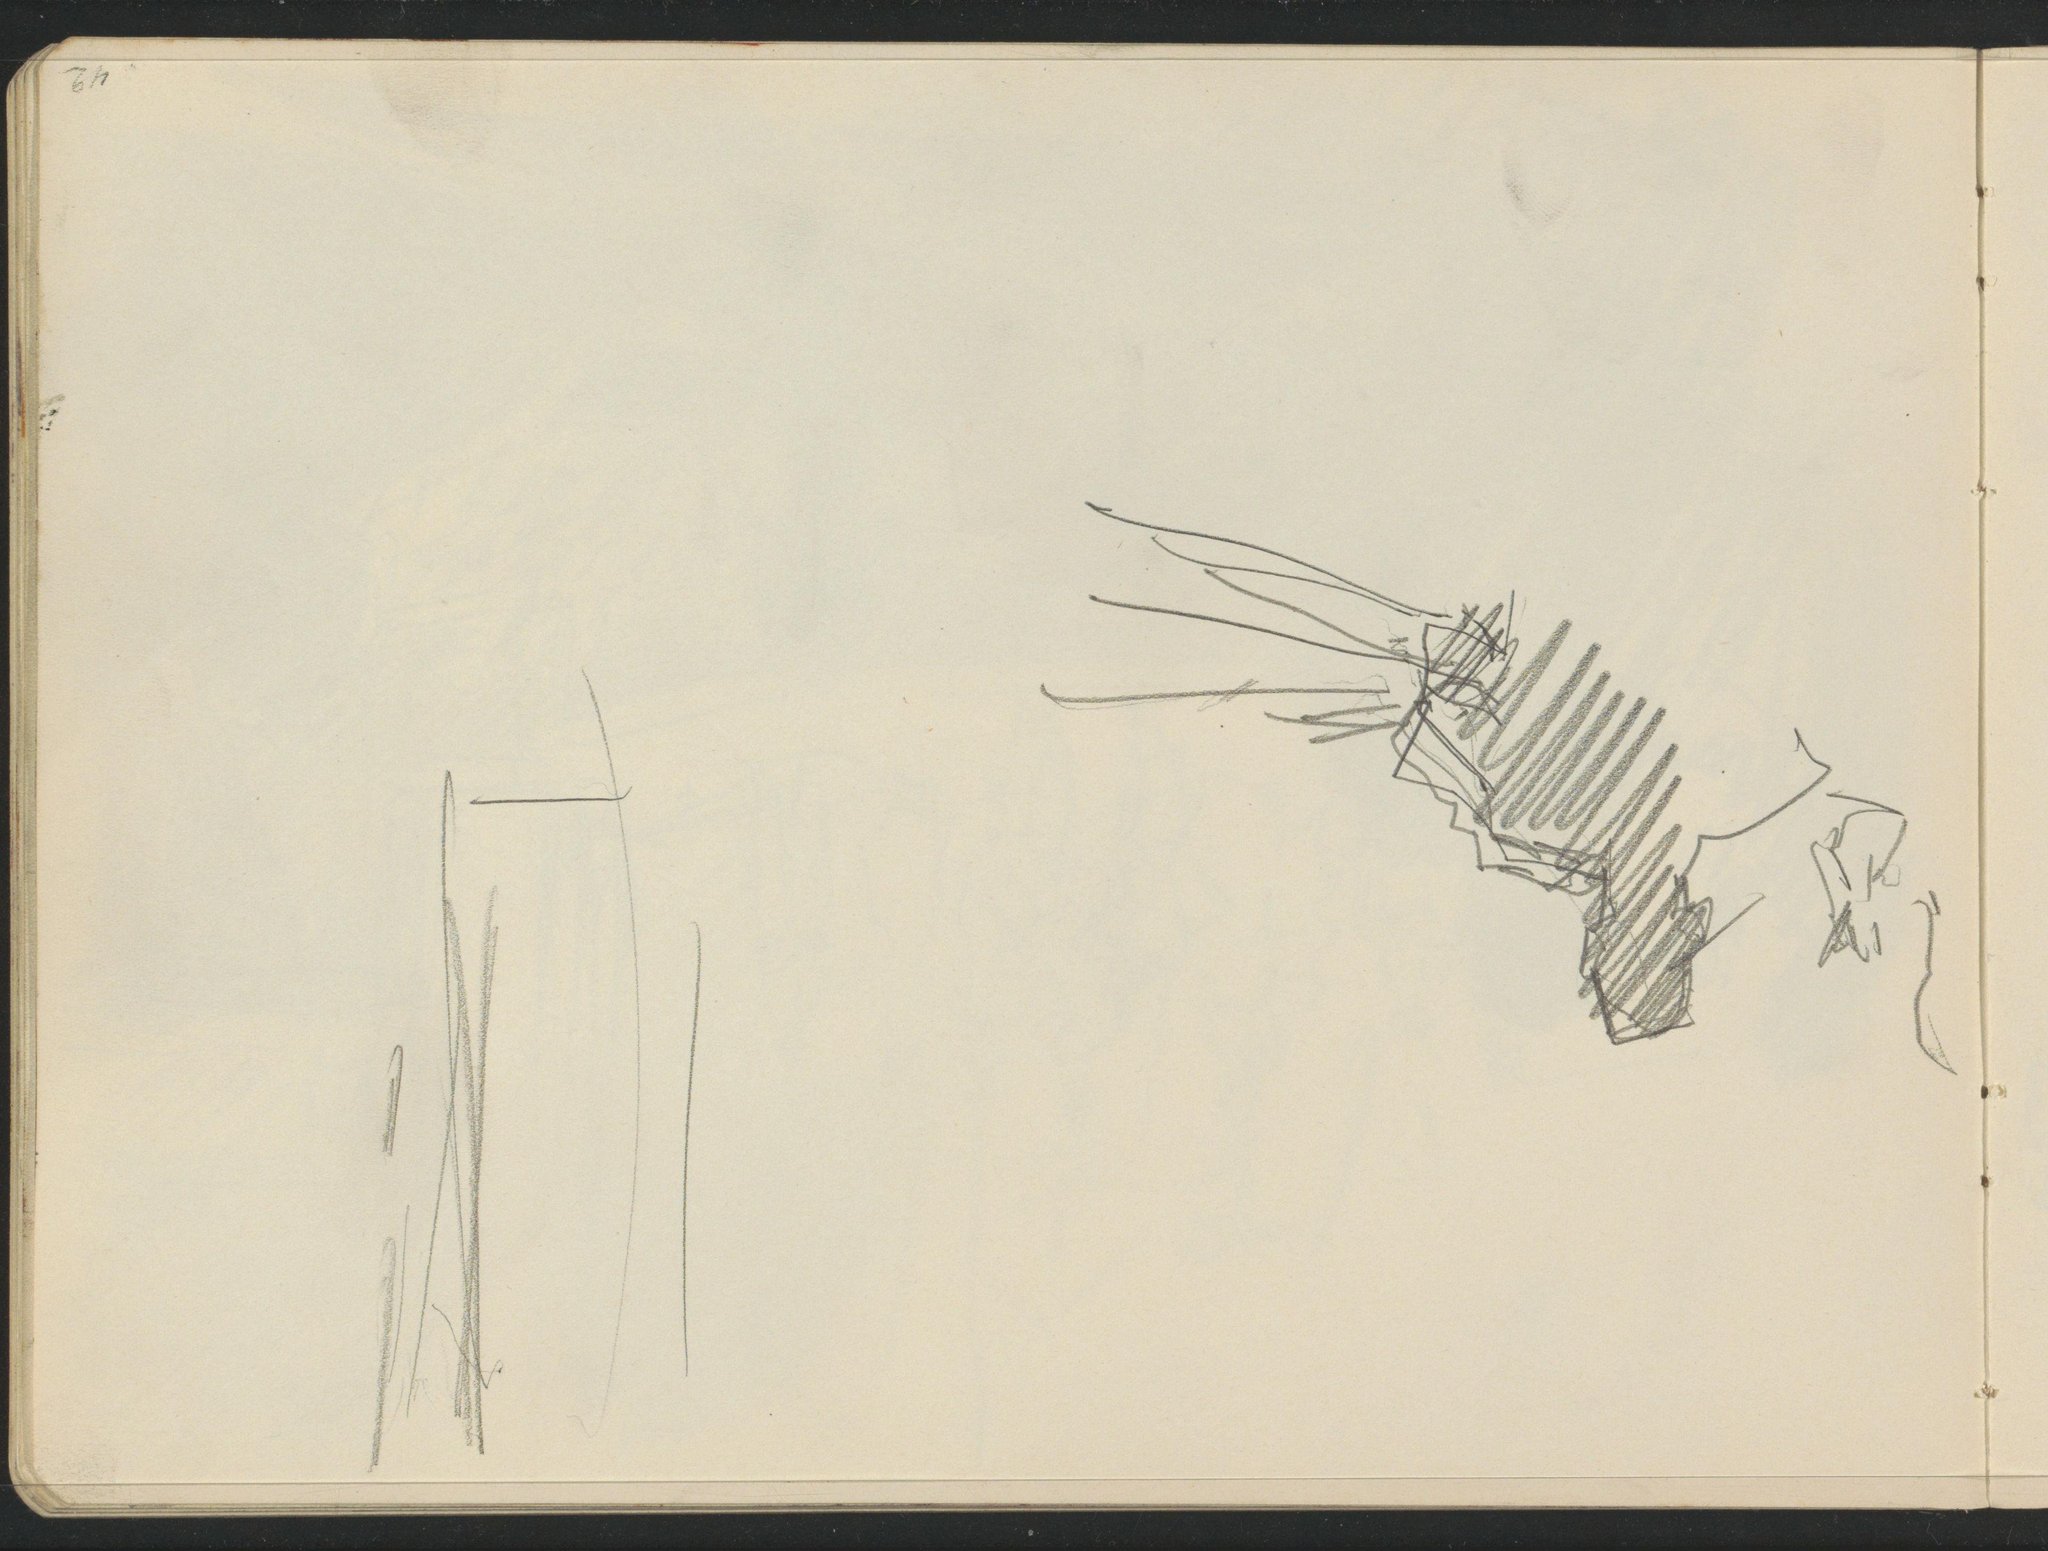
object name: sketchbook leaf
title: Studie, mogelijk van toeschouwers in een theater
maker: isaac israels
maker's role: draughtsman, painter, print maker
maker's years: 1865-1934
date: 1915-1934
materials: paper, pencil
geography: the hague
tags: the audience ~ art performance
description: Blad 29 verso uit schetsboek XVIII met 35 bladen.